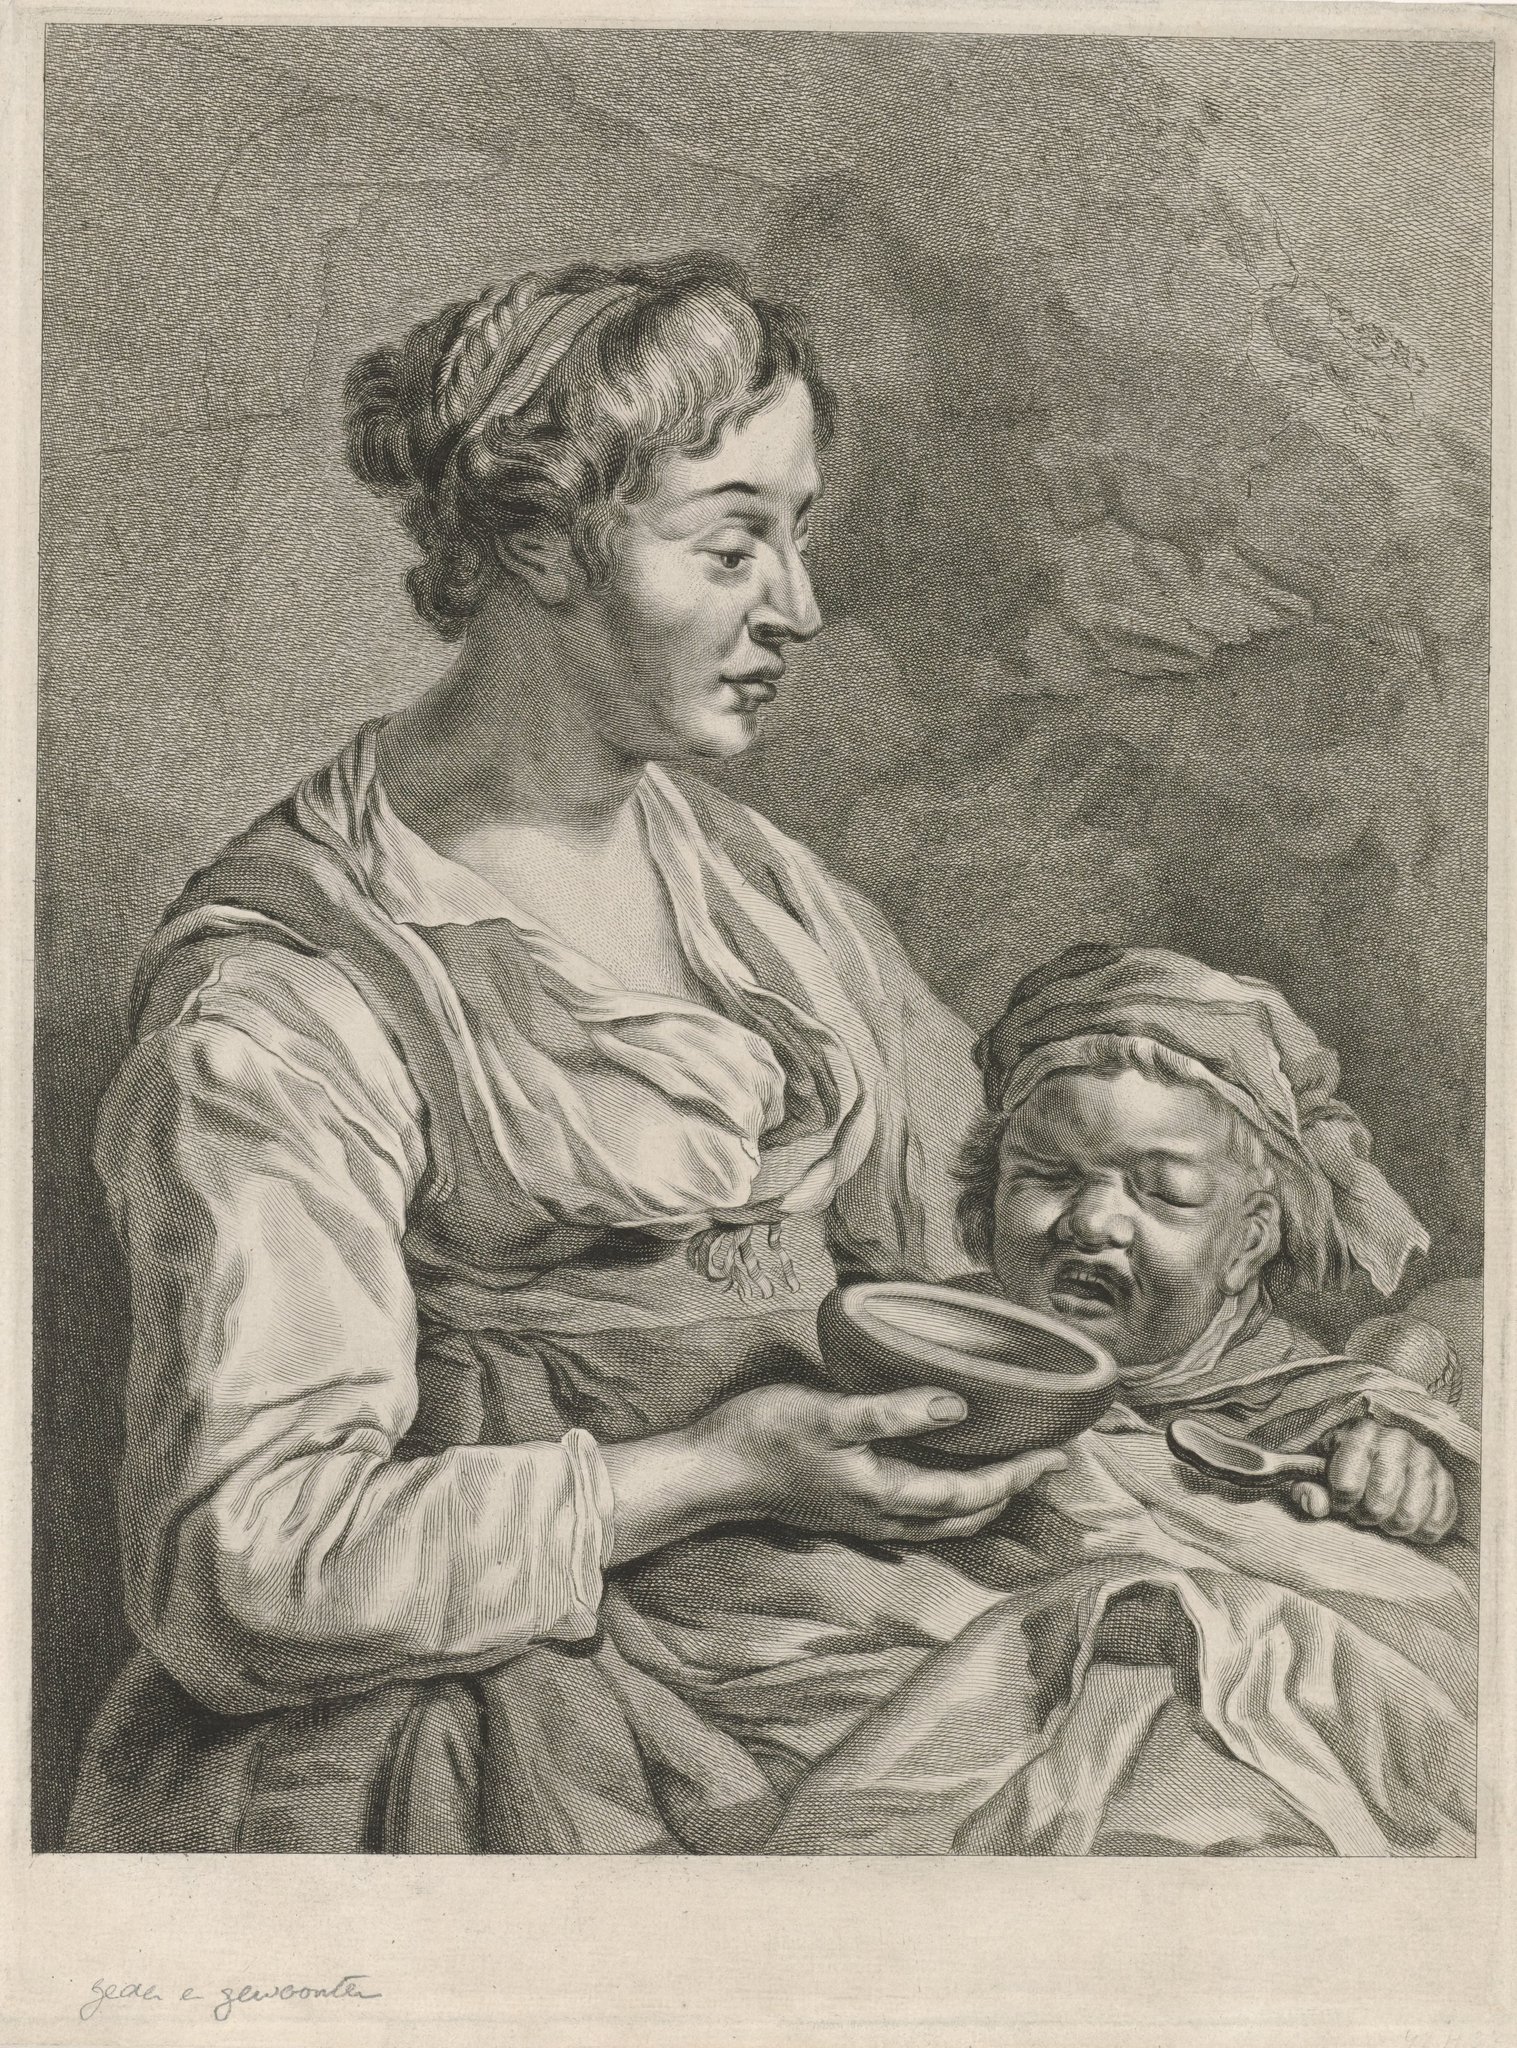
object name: print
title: Moeder geeft haar kind te eten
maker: pieter de mare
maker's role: print maker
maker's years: 1758-1796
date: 1786-1796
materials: paper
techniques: engraving, etching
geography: leiden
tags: feeding a baby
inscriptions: collector's mark: Lugt 240, collector's mark: Lugt 2228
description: Zeden en gewoonten. Des menschen begin, midden en einde afd. Kinderleven